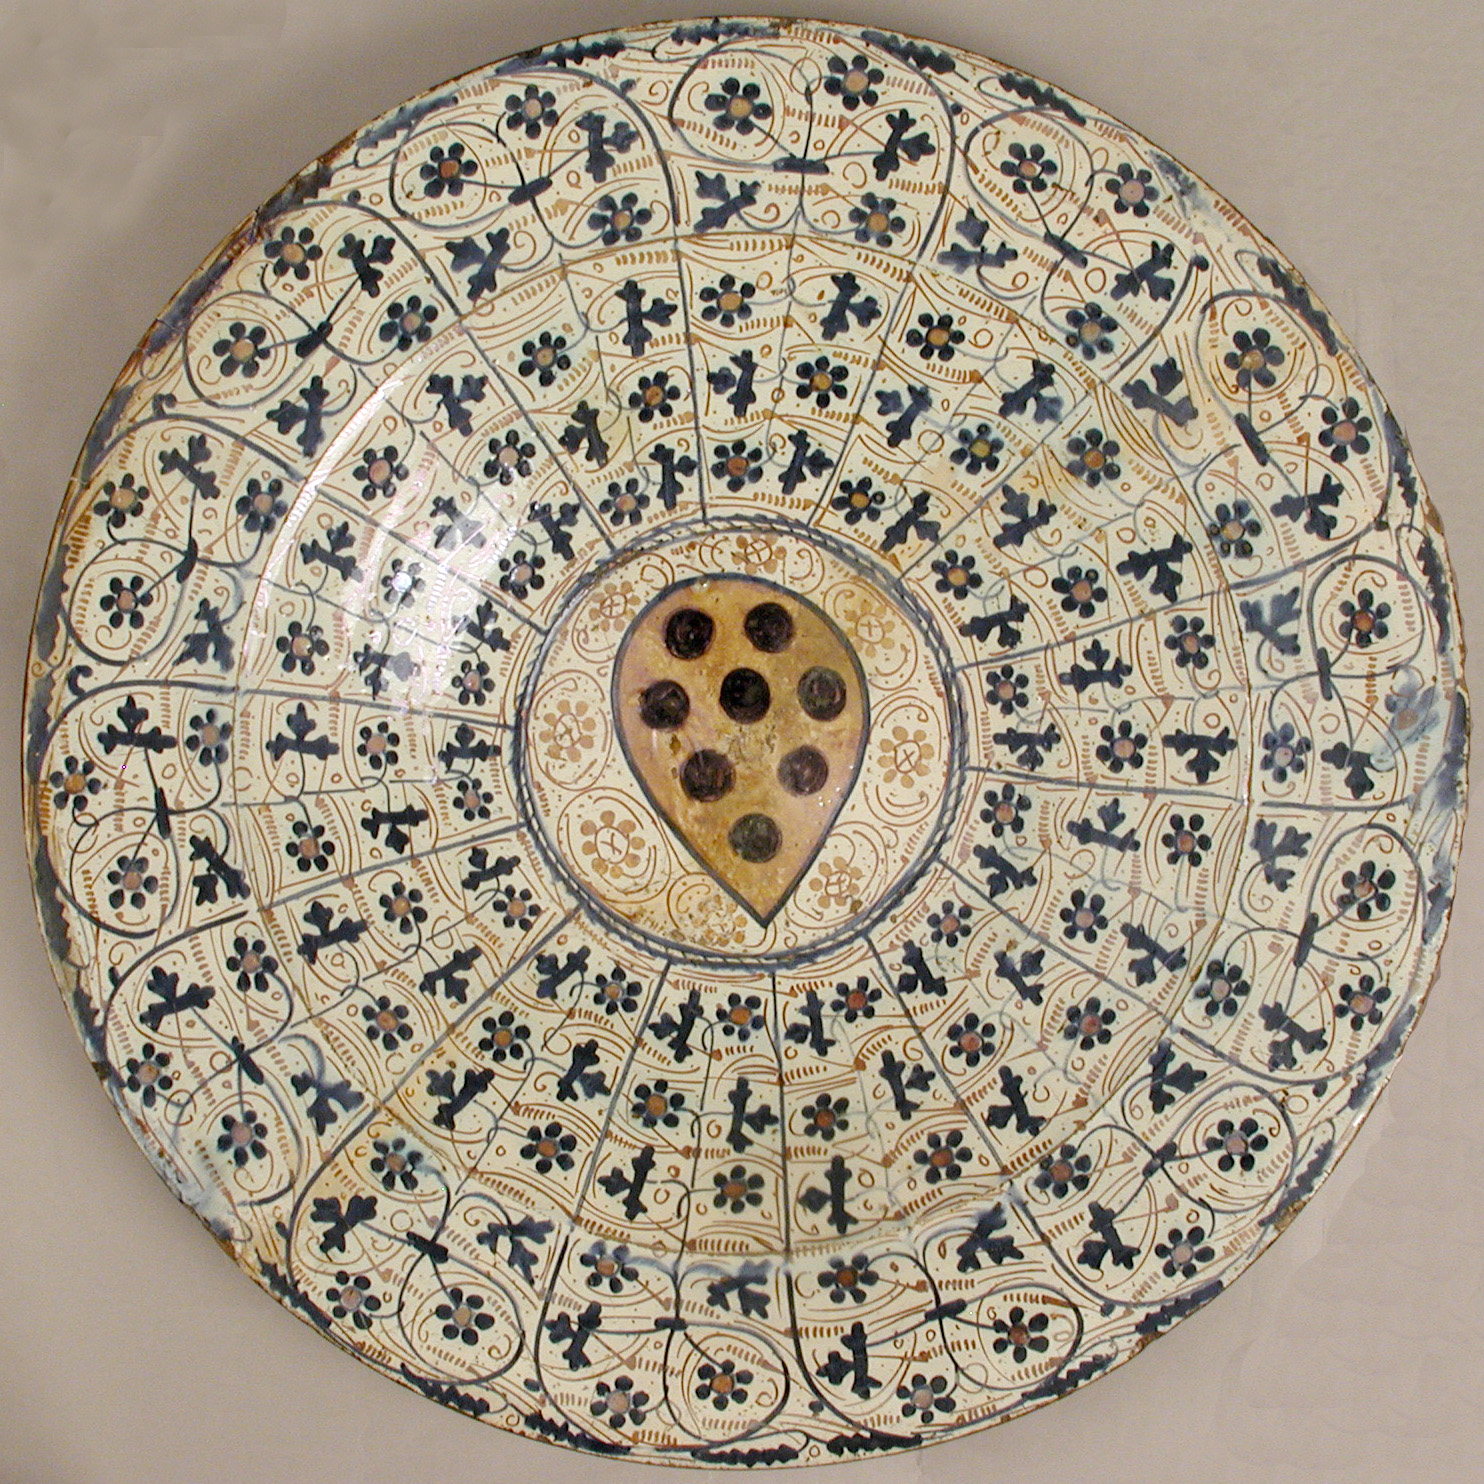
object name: plate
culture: spanish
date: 1450-1500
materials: earthenware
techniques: glazing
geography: spain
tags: flowers